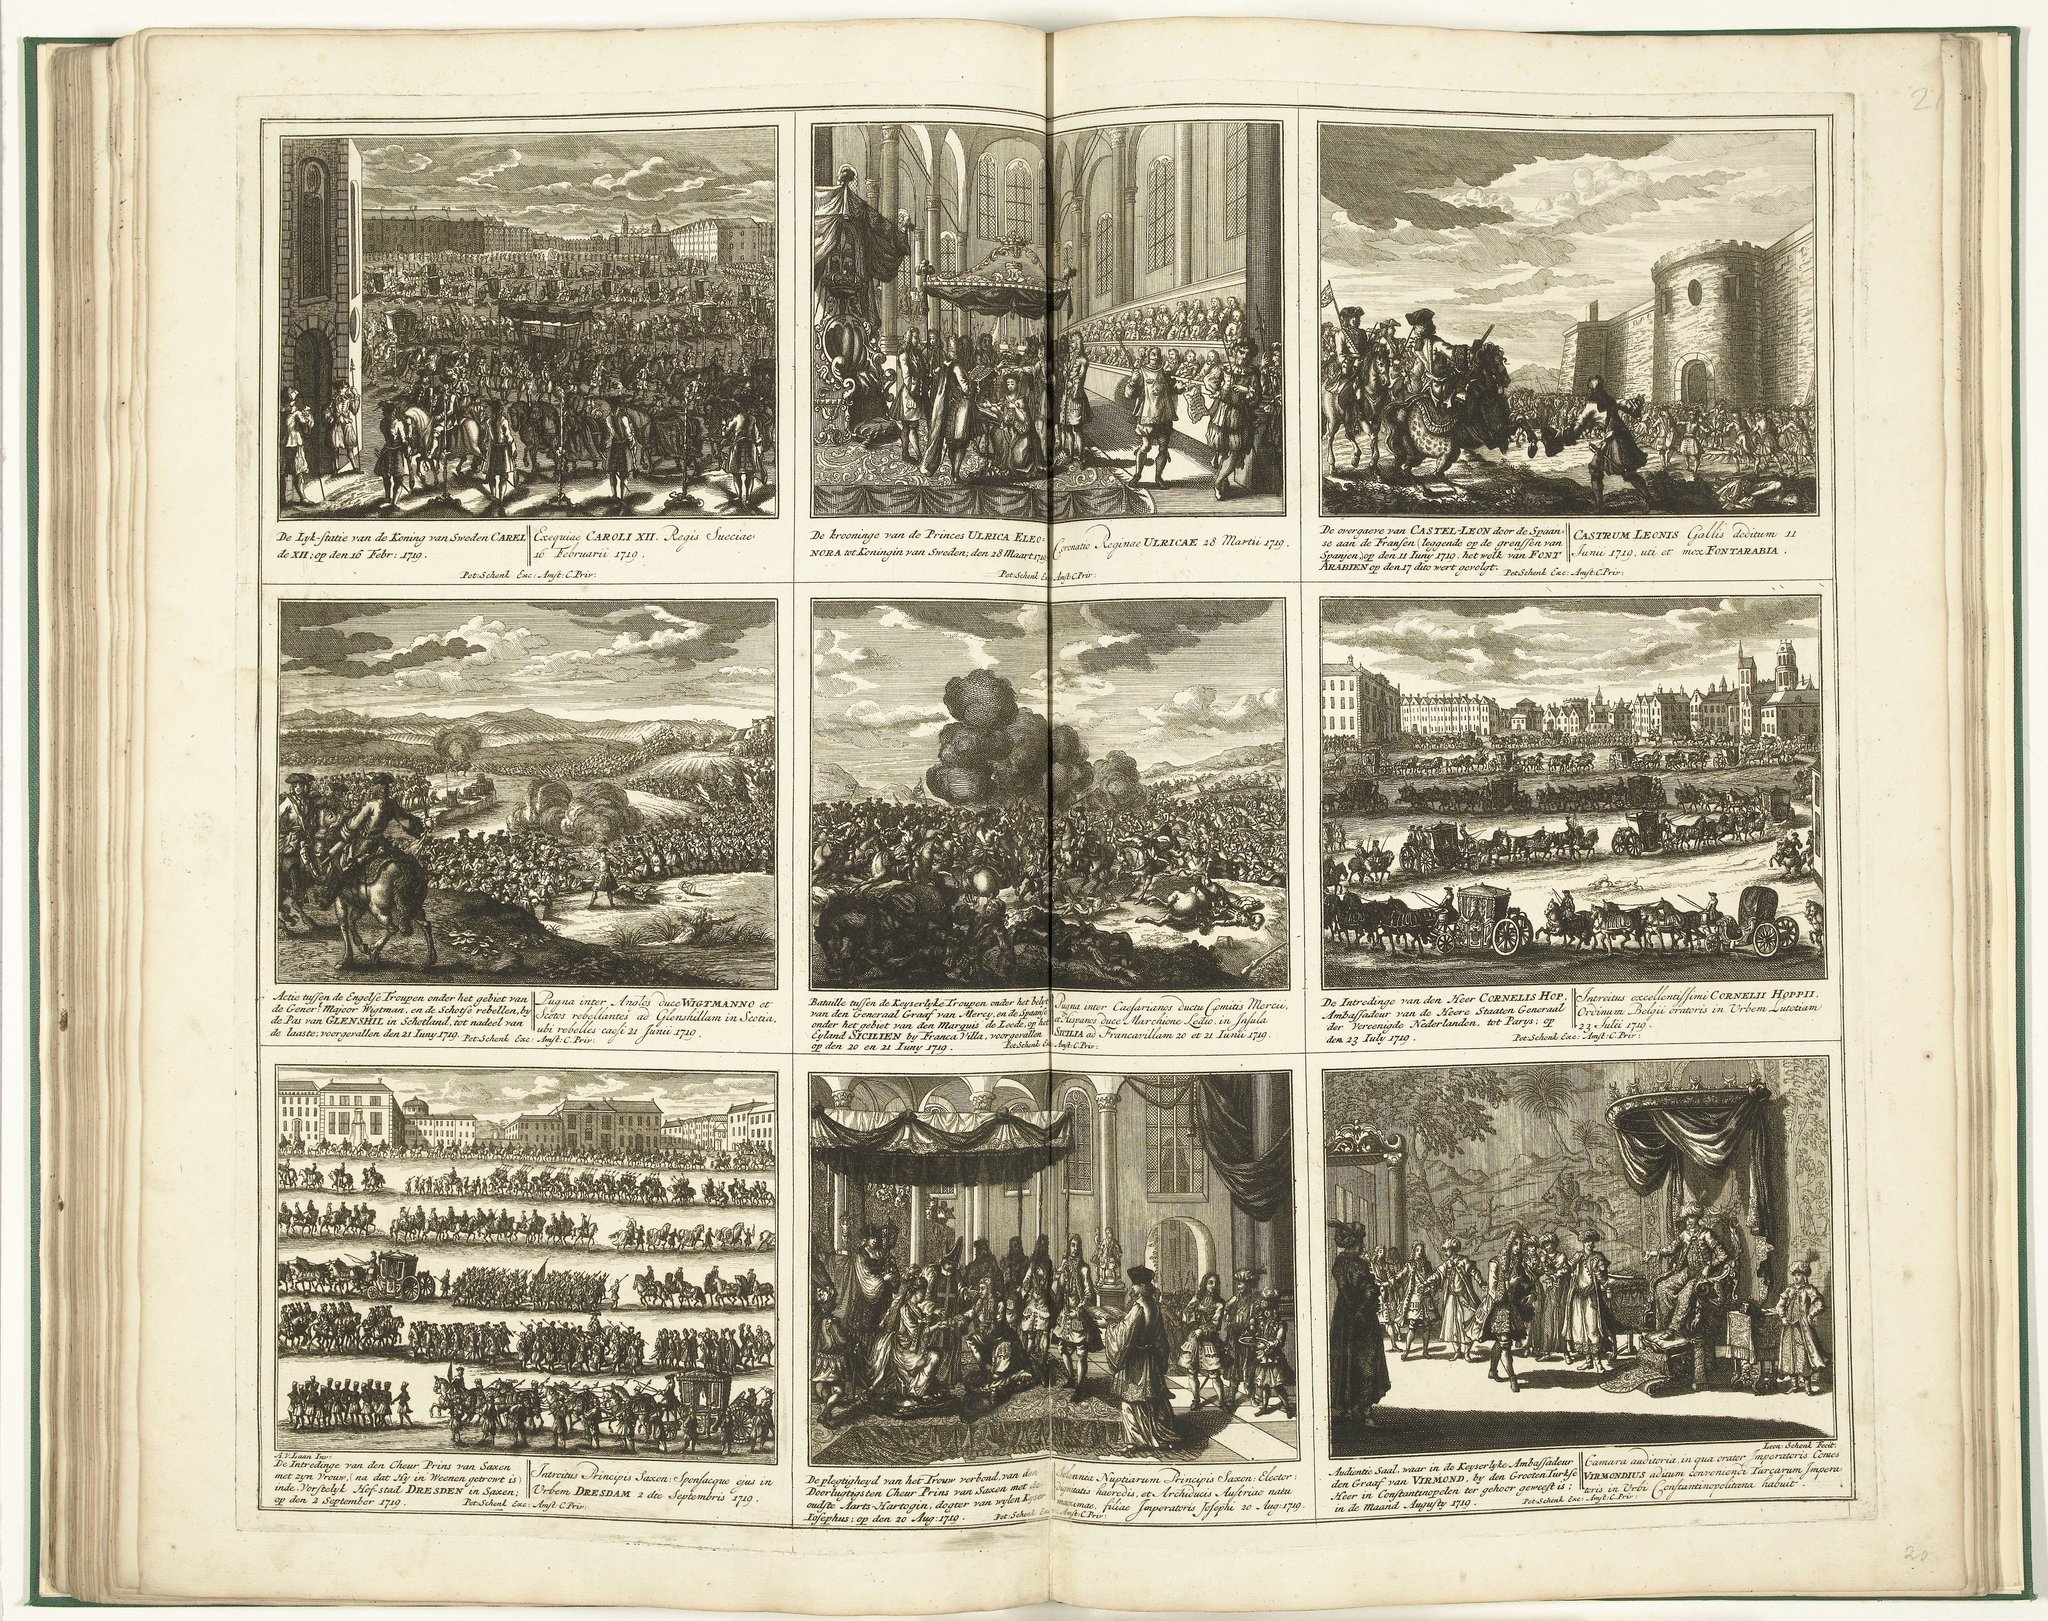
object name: print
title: Schouwburg van den Oorlog, Beginnende van Koning Karel den II. Tot op Koning Karel den III. Bestaande in IX. Historische Figuren op een Olifants Blad, als Veldslagen, Belegeringen te Water en te Lande, met de voornaamste Vestingen (...)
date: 1719-1720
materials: paper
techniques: etching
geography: amsterdam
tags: amsterdam, london, coronation of a ruler, cortege, funeral procession, (civil) marriage ceremonies, battle (+ land forces), paris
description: Blad met negen voorstellingen van gebeurtenissen uit het jaar 1719. Blad XX in: Schouwburg van den oorlog (editie van 1720), het prentwerk met de gebundelde reeks van 31 platen over de Spaanse Successieoorlog.